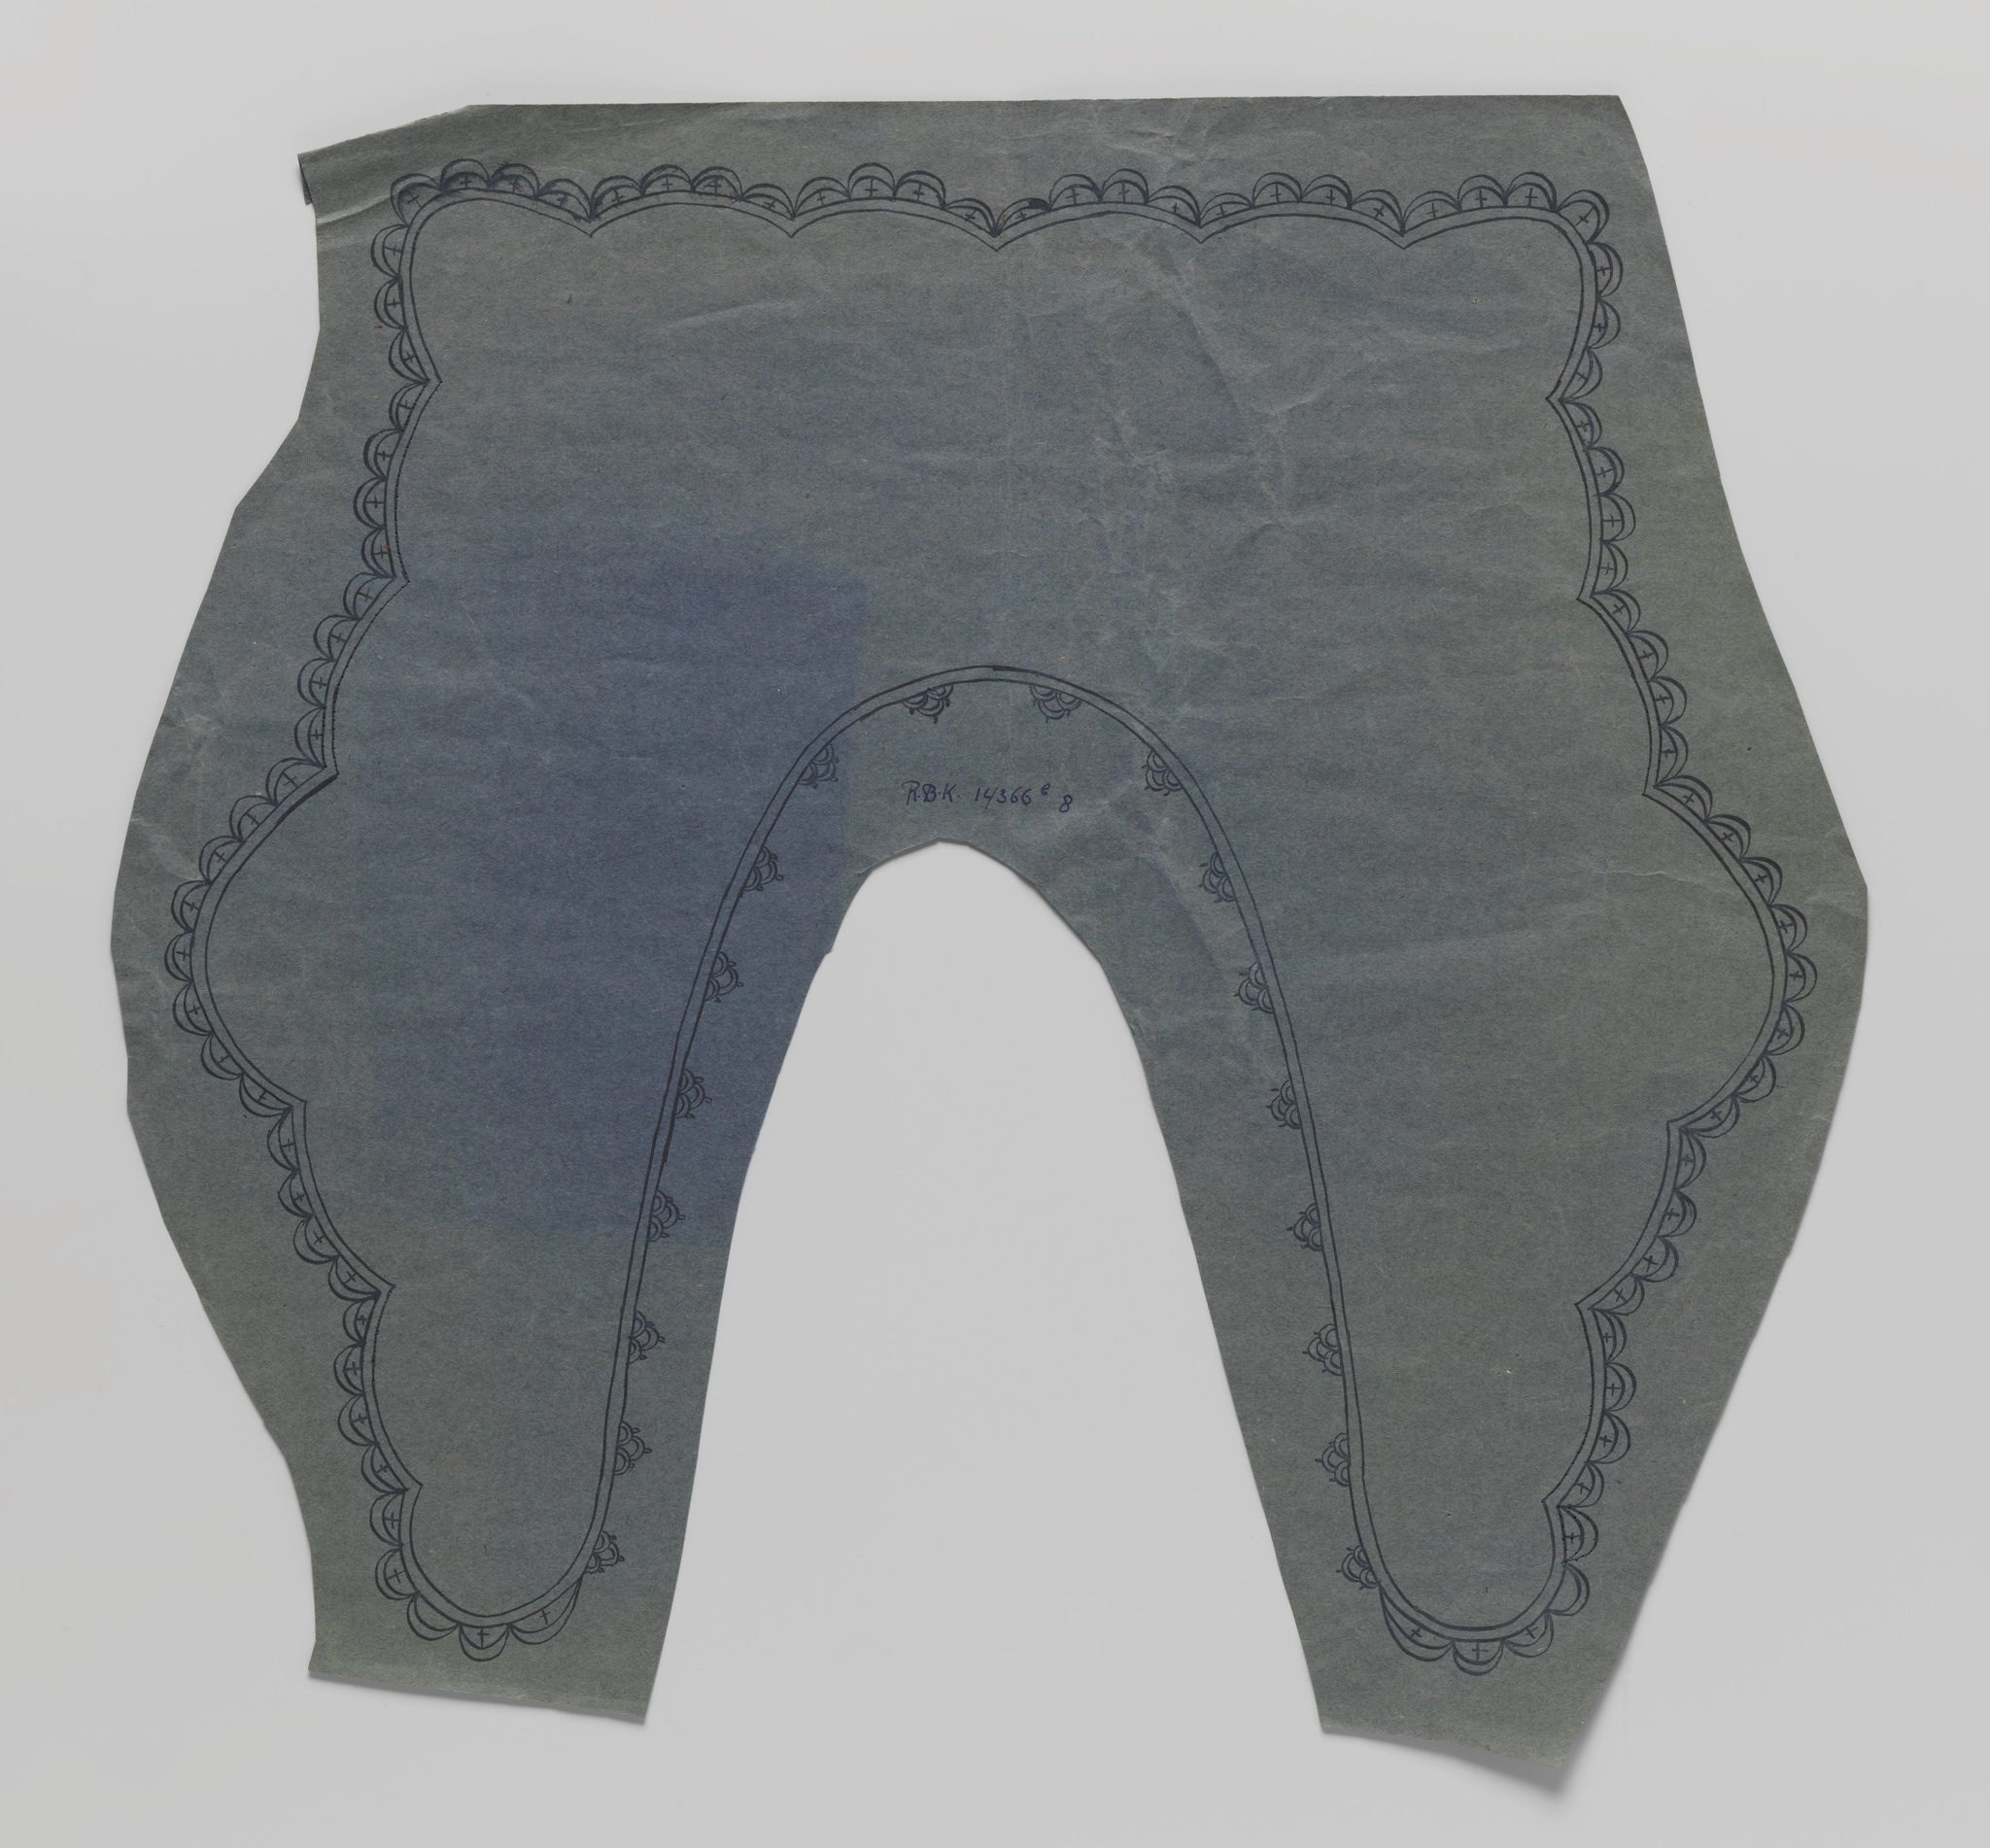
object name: prikking naaldkant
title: Naaldkantpatroon voor de randen van een kraag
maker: johanna e. van nierop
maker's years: 1882-1970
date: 1915-1925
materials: paper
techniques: drawing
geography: amersfoort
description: Naaldkantpatroon voor de randen van een kraag van Venetiaanse naaldkant, met inkt getekend op blauw papier. De (rand van de) kraag heeft een u-vormig model met schulpen langs de buitenzijde. De onderkant van de u-vorm is aan de buitenzijde niet rond maar afgeplat, de schulpenrand loopt hier wel gewoon door. Op sommige plekken is begonnen met het maken van gaatjes om de traceerlijnen straks doorheen te naaien. Het patroon wordt dan een 'prikking' die met de traceerlijnen op een dubbele katoenen ondergrond wordt gezet. Als vervolgens naaldkantsteken over en tussen de traceerdraden gemaakt zijn kan de prikking en de katoenen ondergrond worden losgeknipt en verwijderd. Dan hou je alleen naaldkant over, in dit geval de rand van de kraag die dan met de andere delen tot een hele kraag kan worden verwerkt. Het ontwerp van de kraag is gemaakt door een persoon uit België die in de Eerste Wereldoorlog was geïnterneerd in kamp 'Elisabeth-dorp' in Amersfoort. Mevrouw van Nierop is begonnen met het maken van de kraag en heeft de onafgewerkte delen geschonken aan het Rijksmuseum als studiemateriaal.